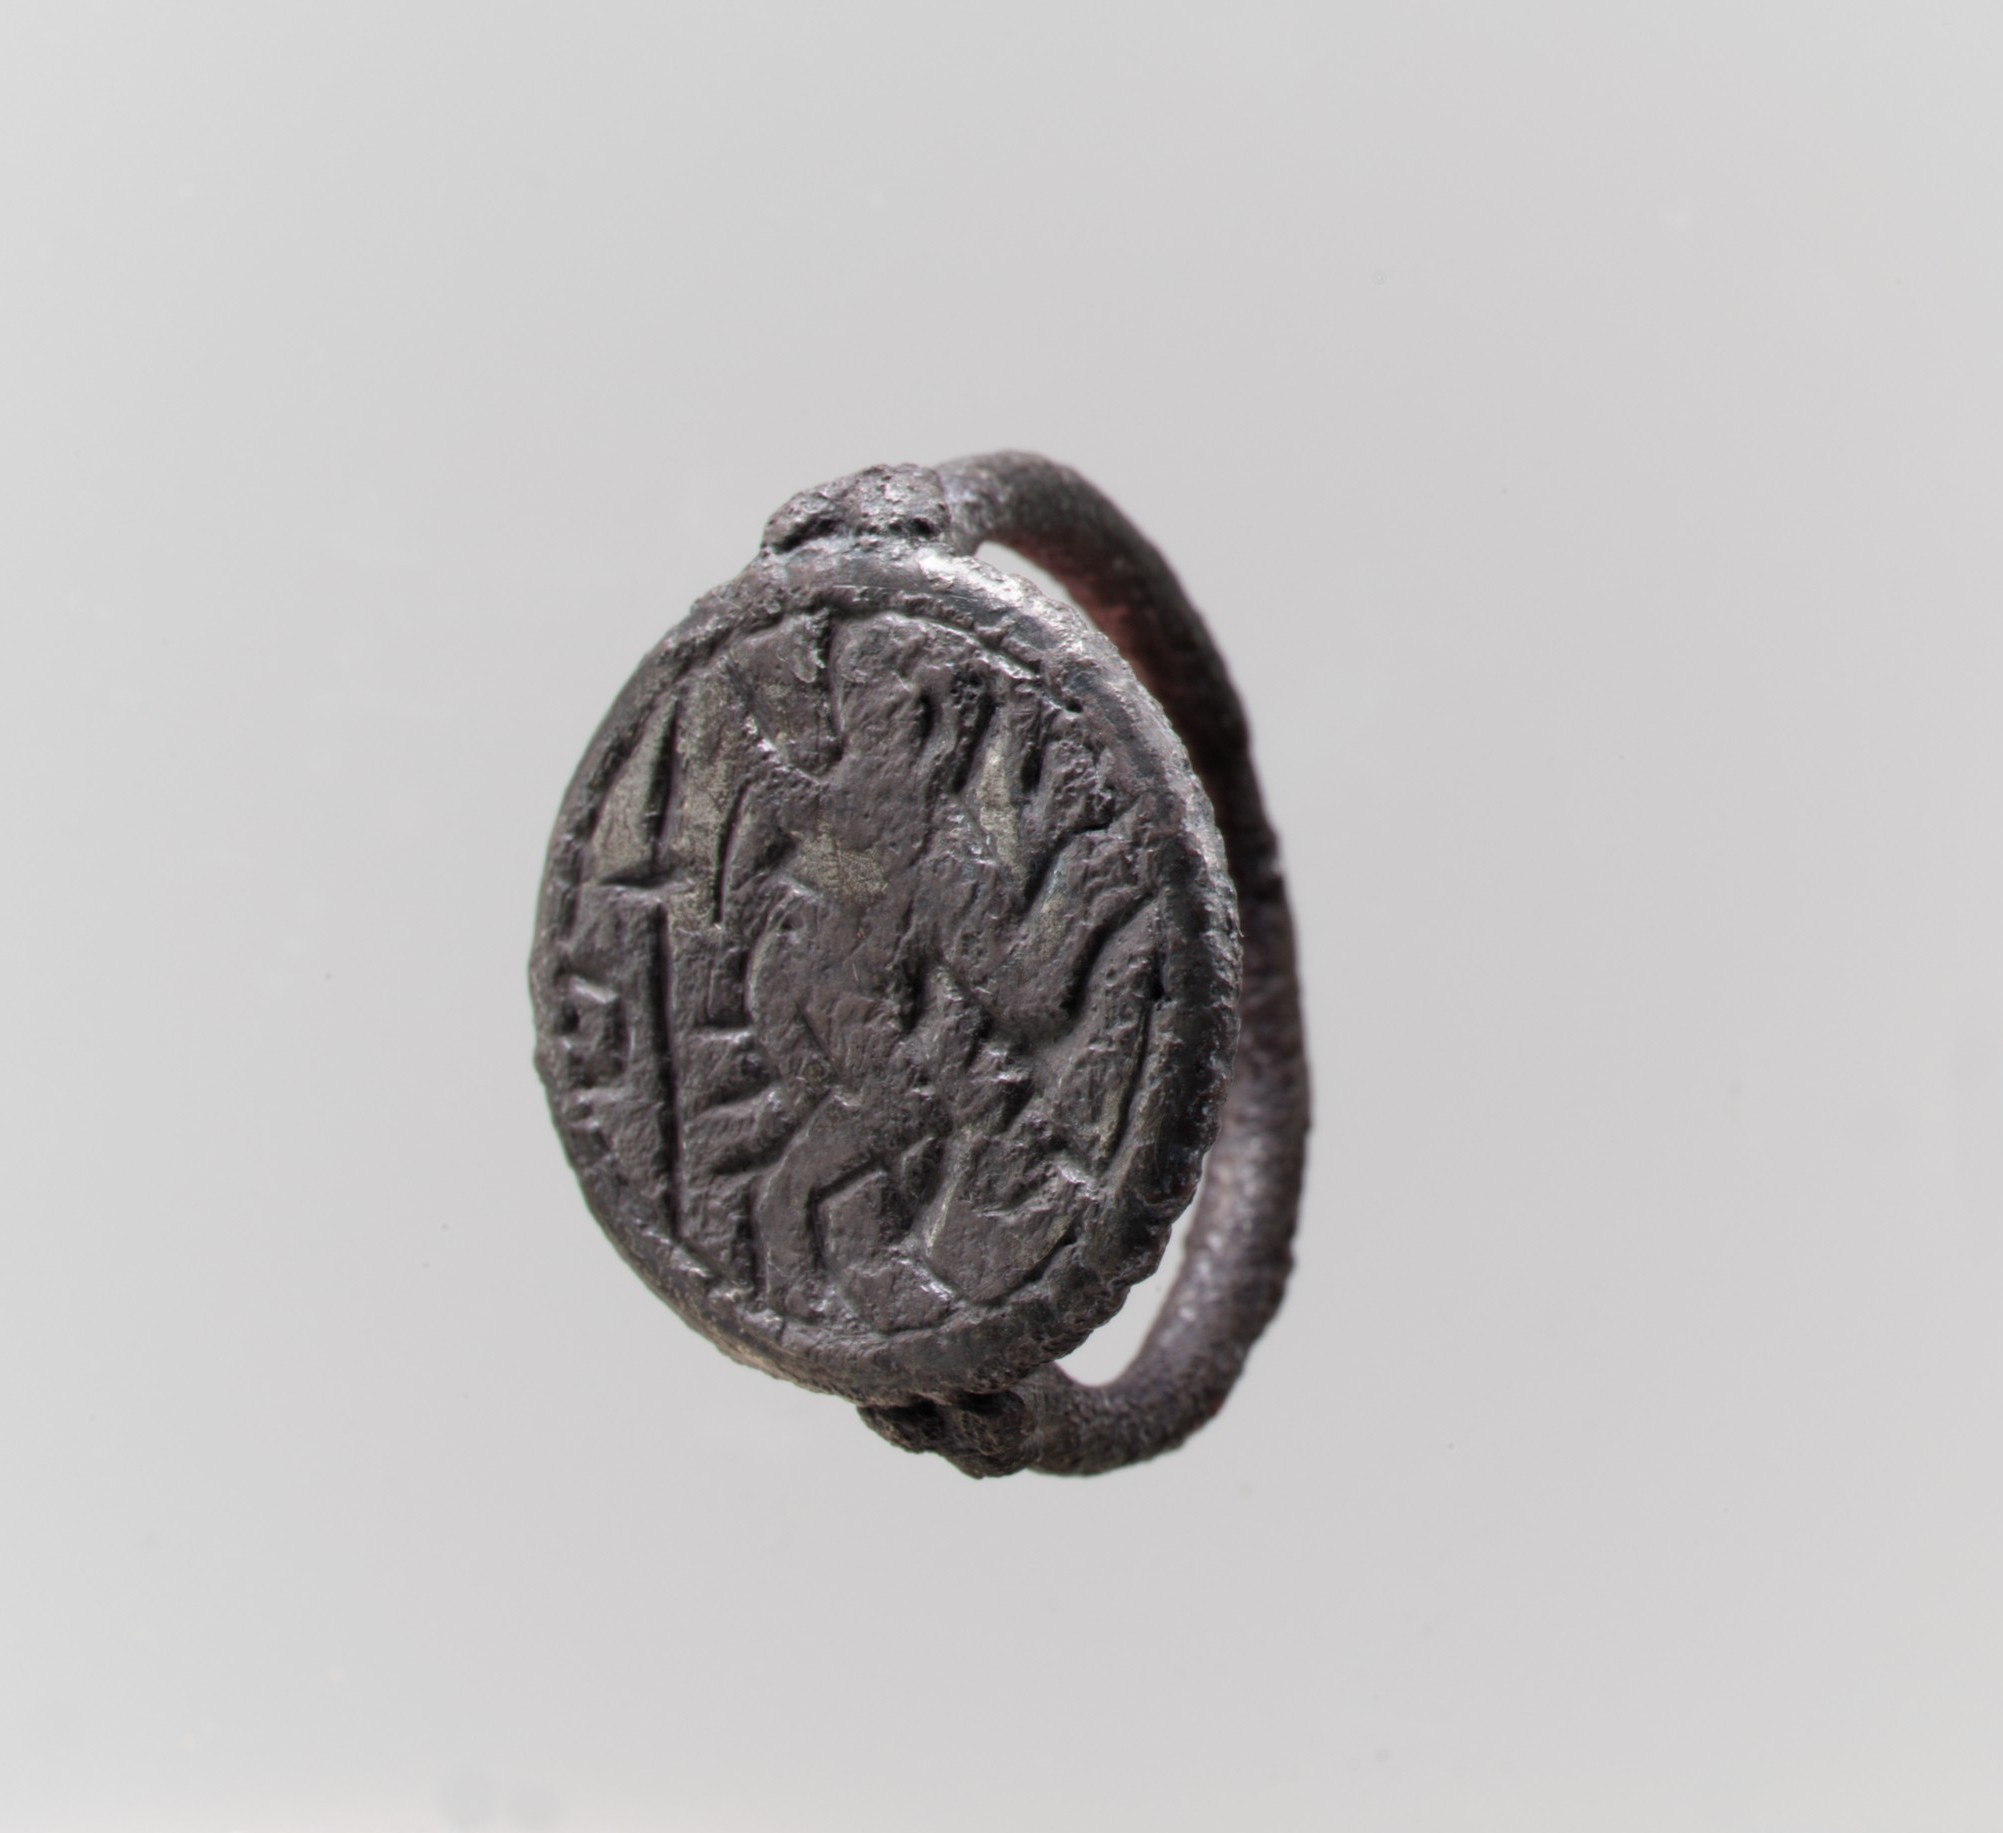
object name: ring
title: Finger Ring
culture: frankish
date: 601-700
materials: silver